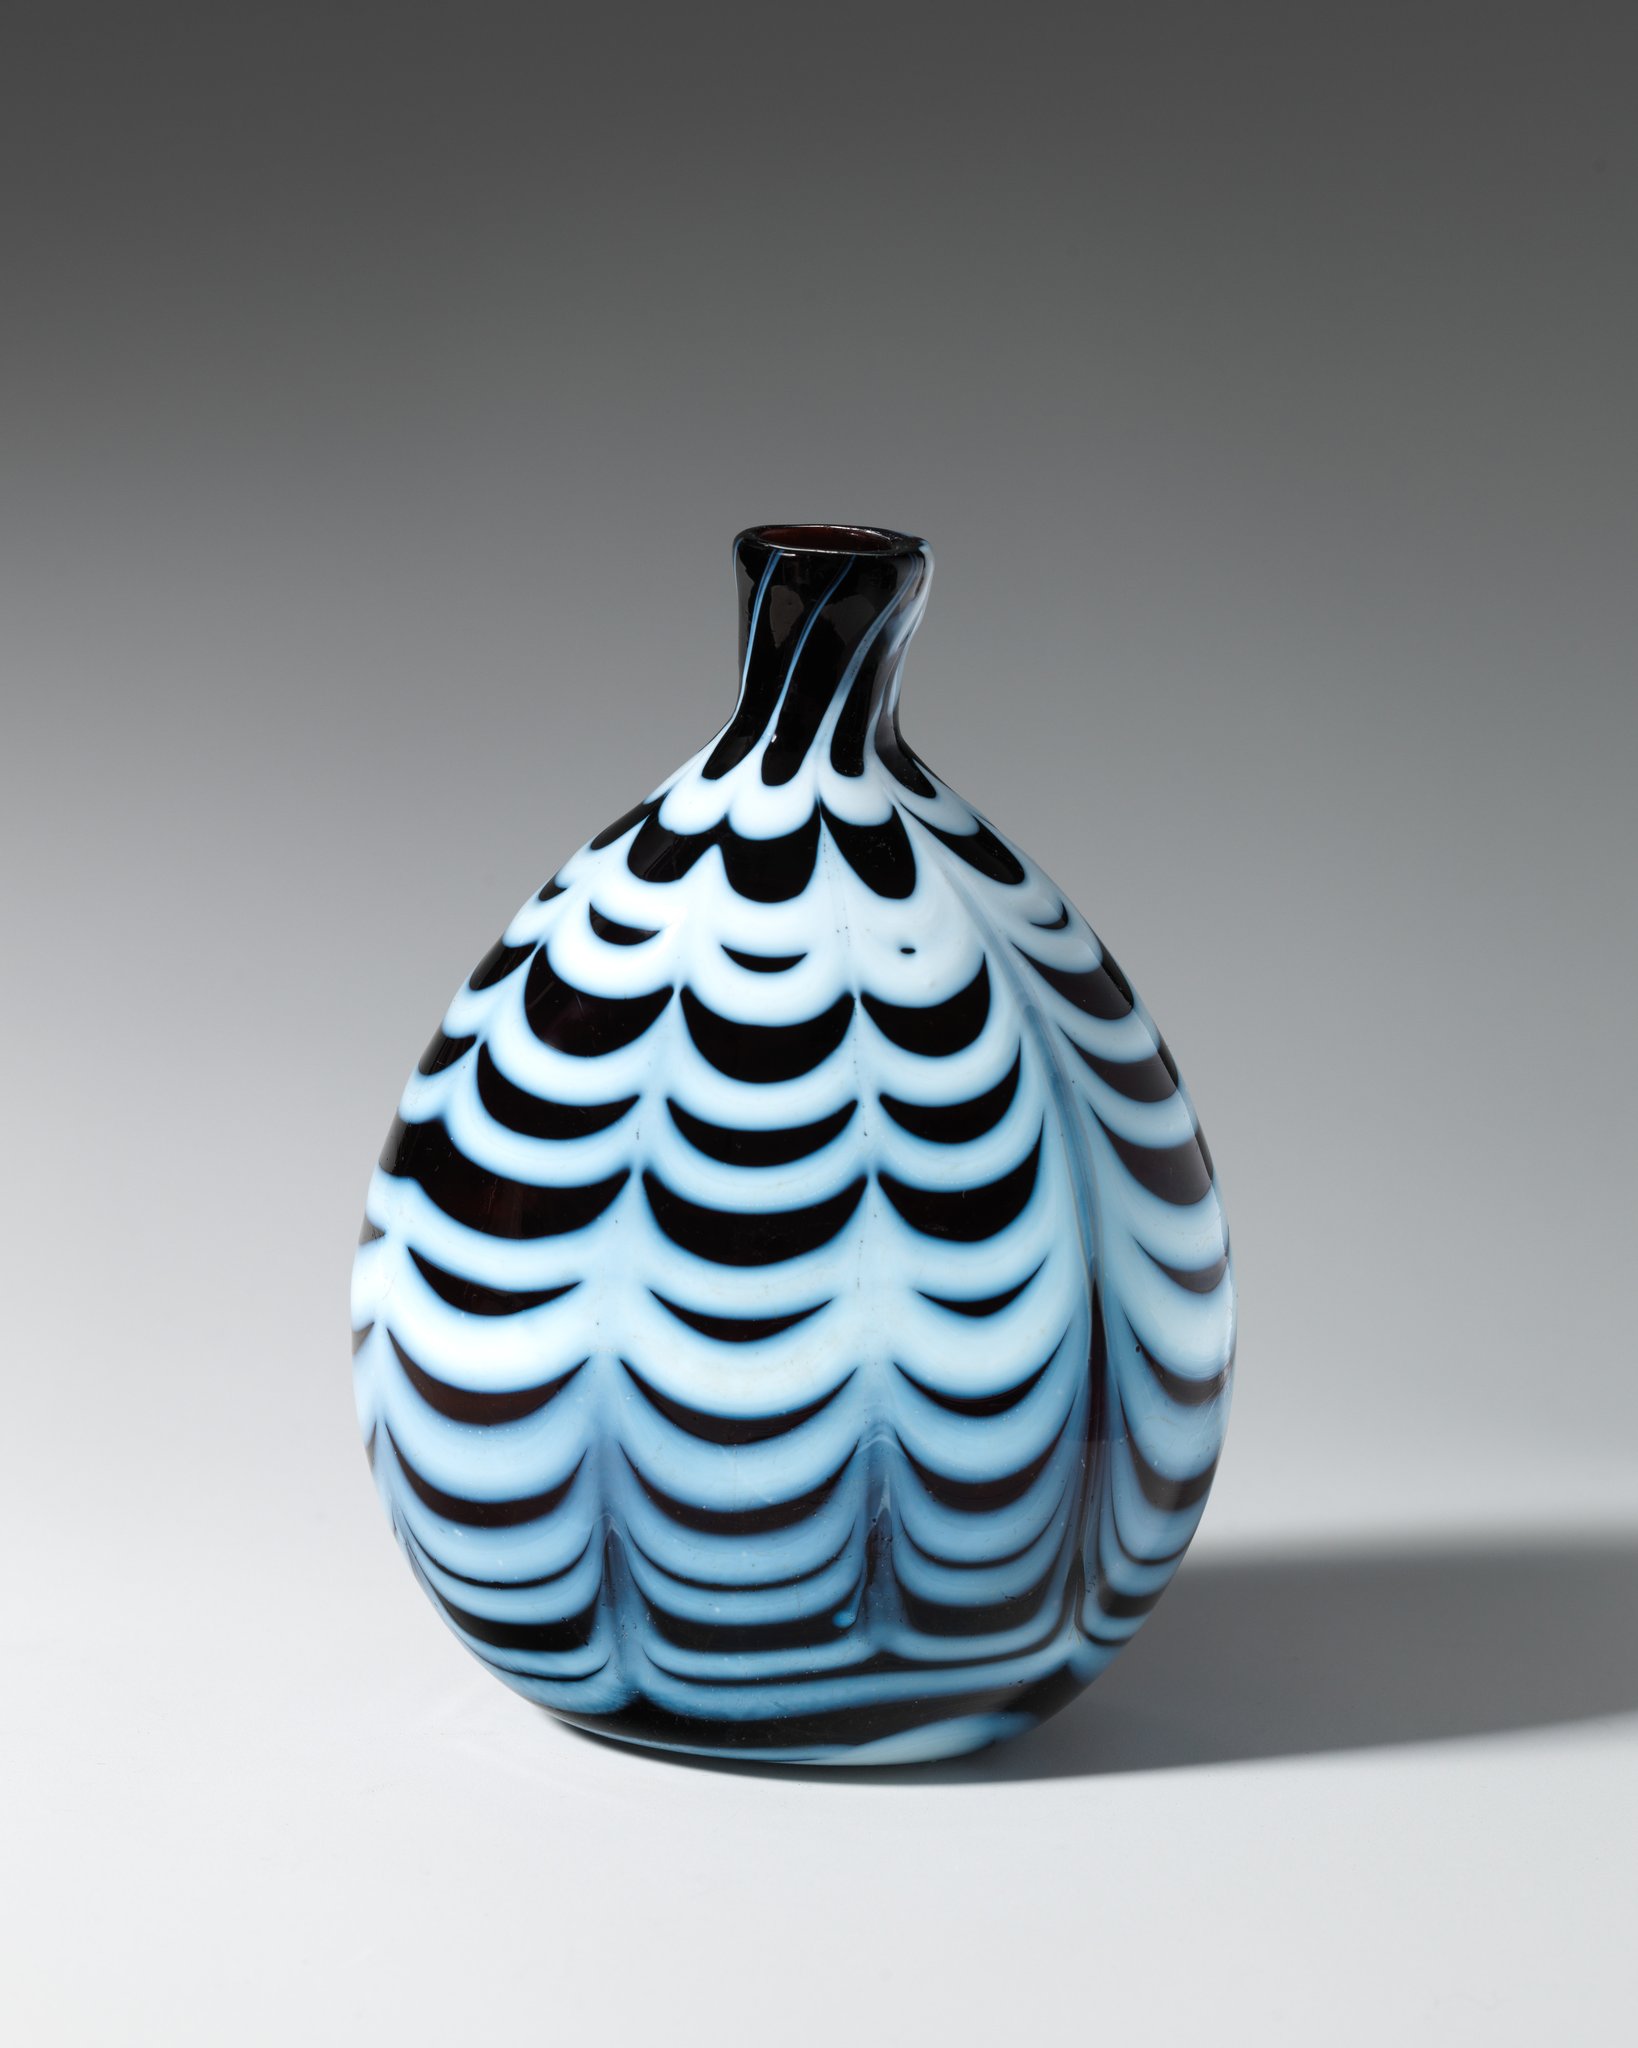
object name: bottle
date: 1701-1900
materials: glass